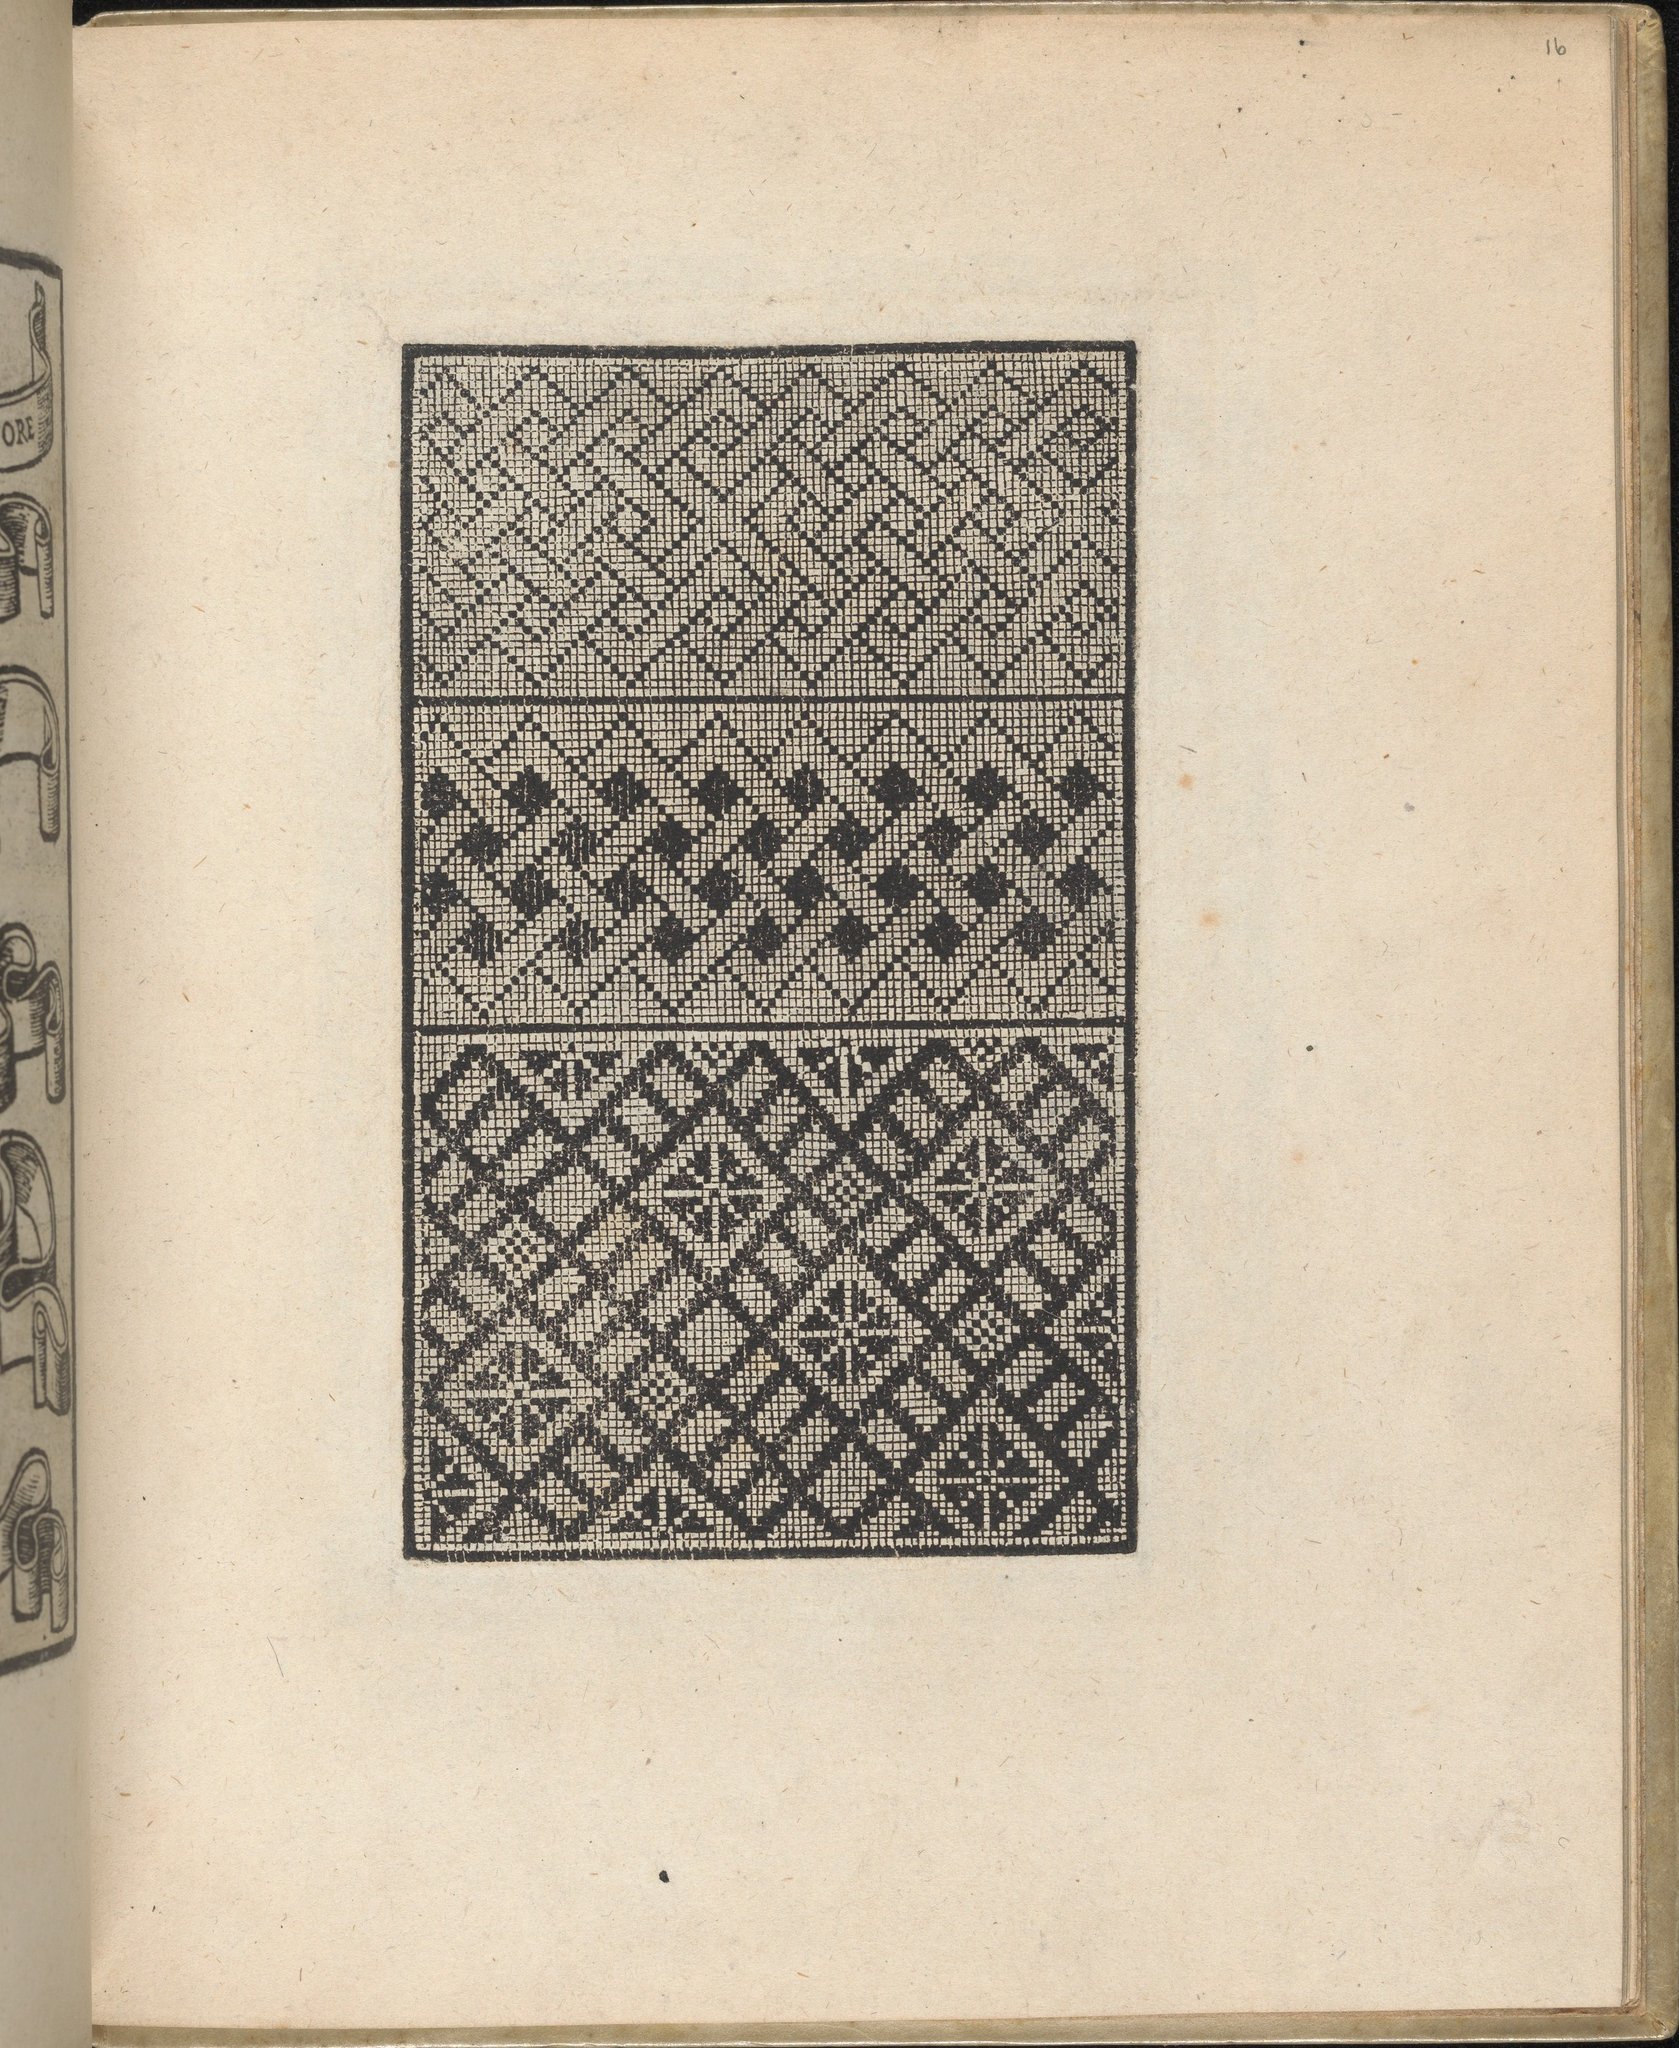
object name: book print ornament architecture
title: Trionfo Di Virtu. Libro Novo..., page 16 (verso)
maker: matteo pagano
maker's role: publisher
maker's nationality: italian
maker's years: 1515-1588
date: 1563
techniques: woodcut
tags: ornament